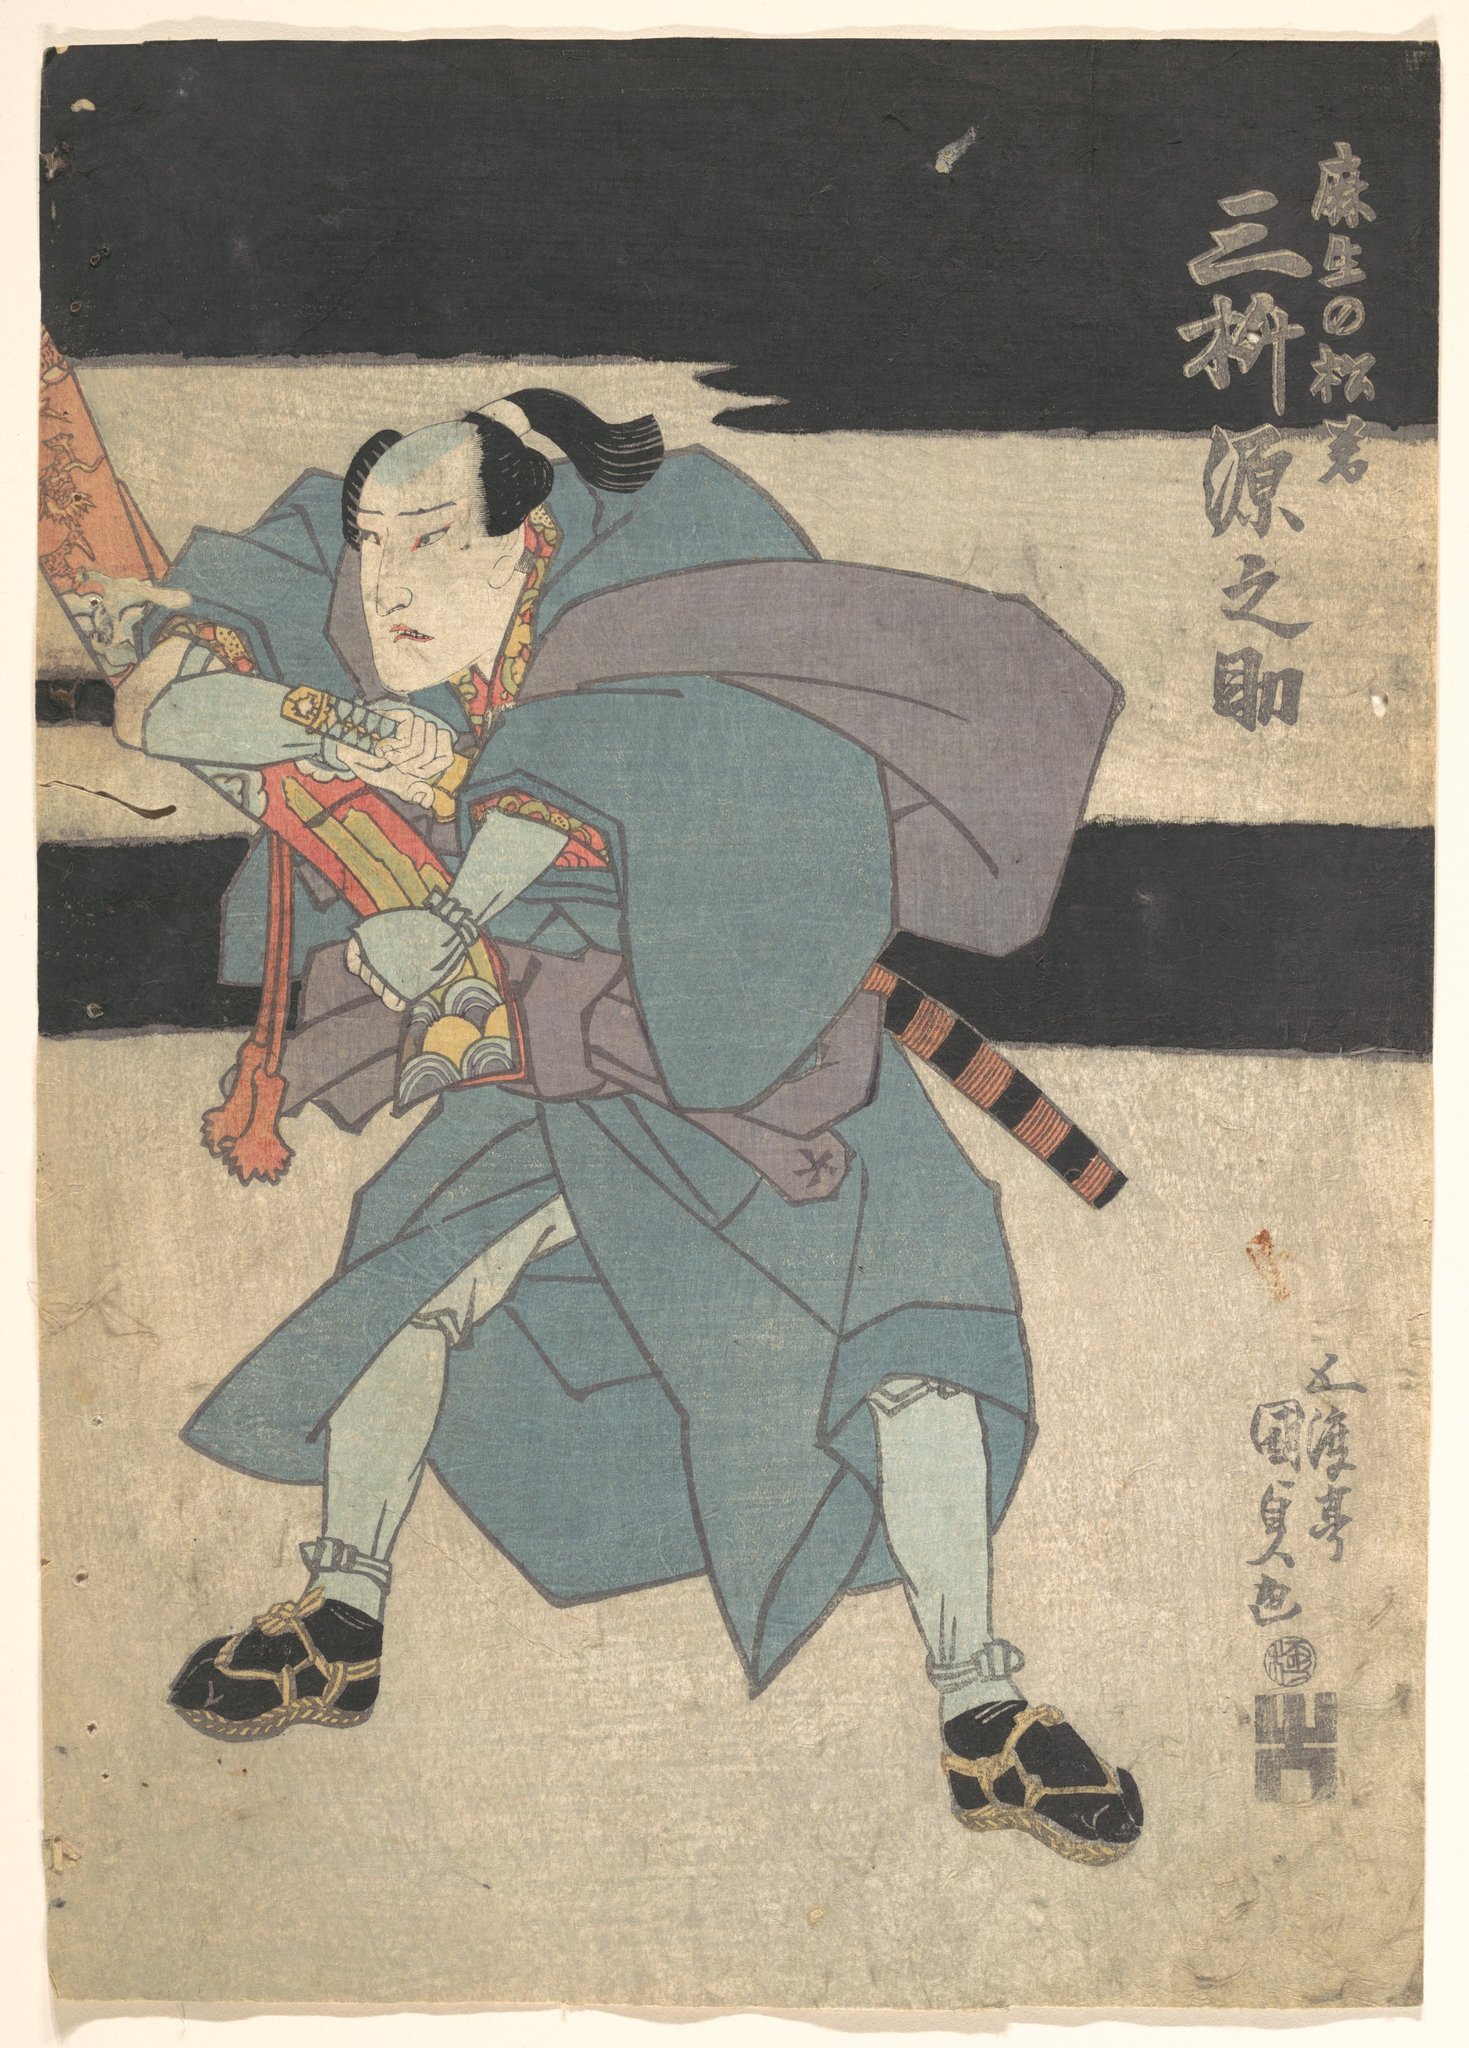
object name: print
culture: japanese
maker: utagawa kunisada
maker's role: artist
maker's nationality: japanese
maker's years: 1786-1864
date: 1801-1900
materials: ink, paper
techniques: woodblock print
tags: swords,men